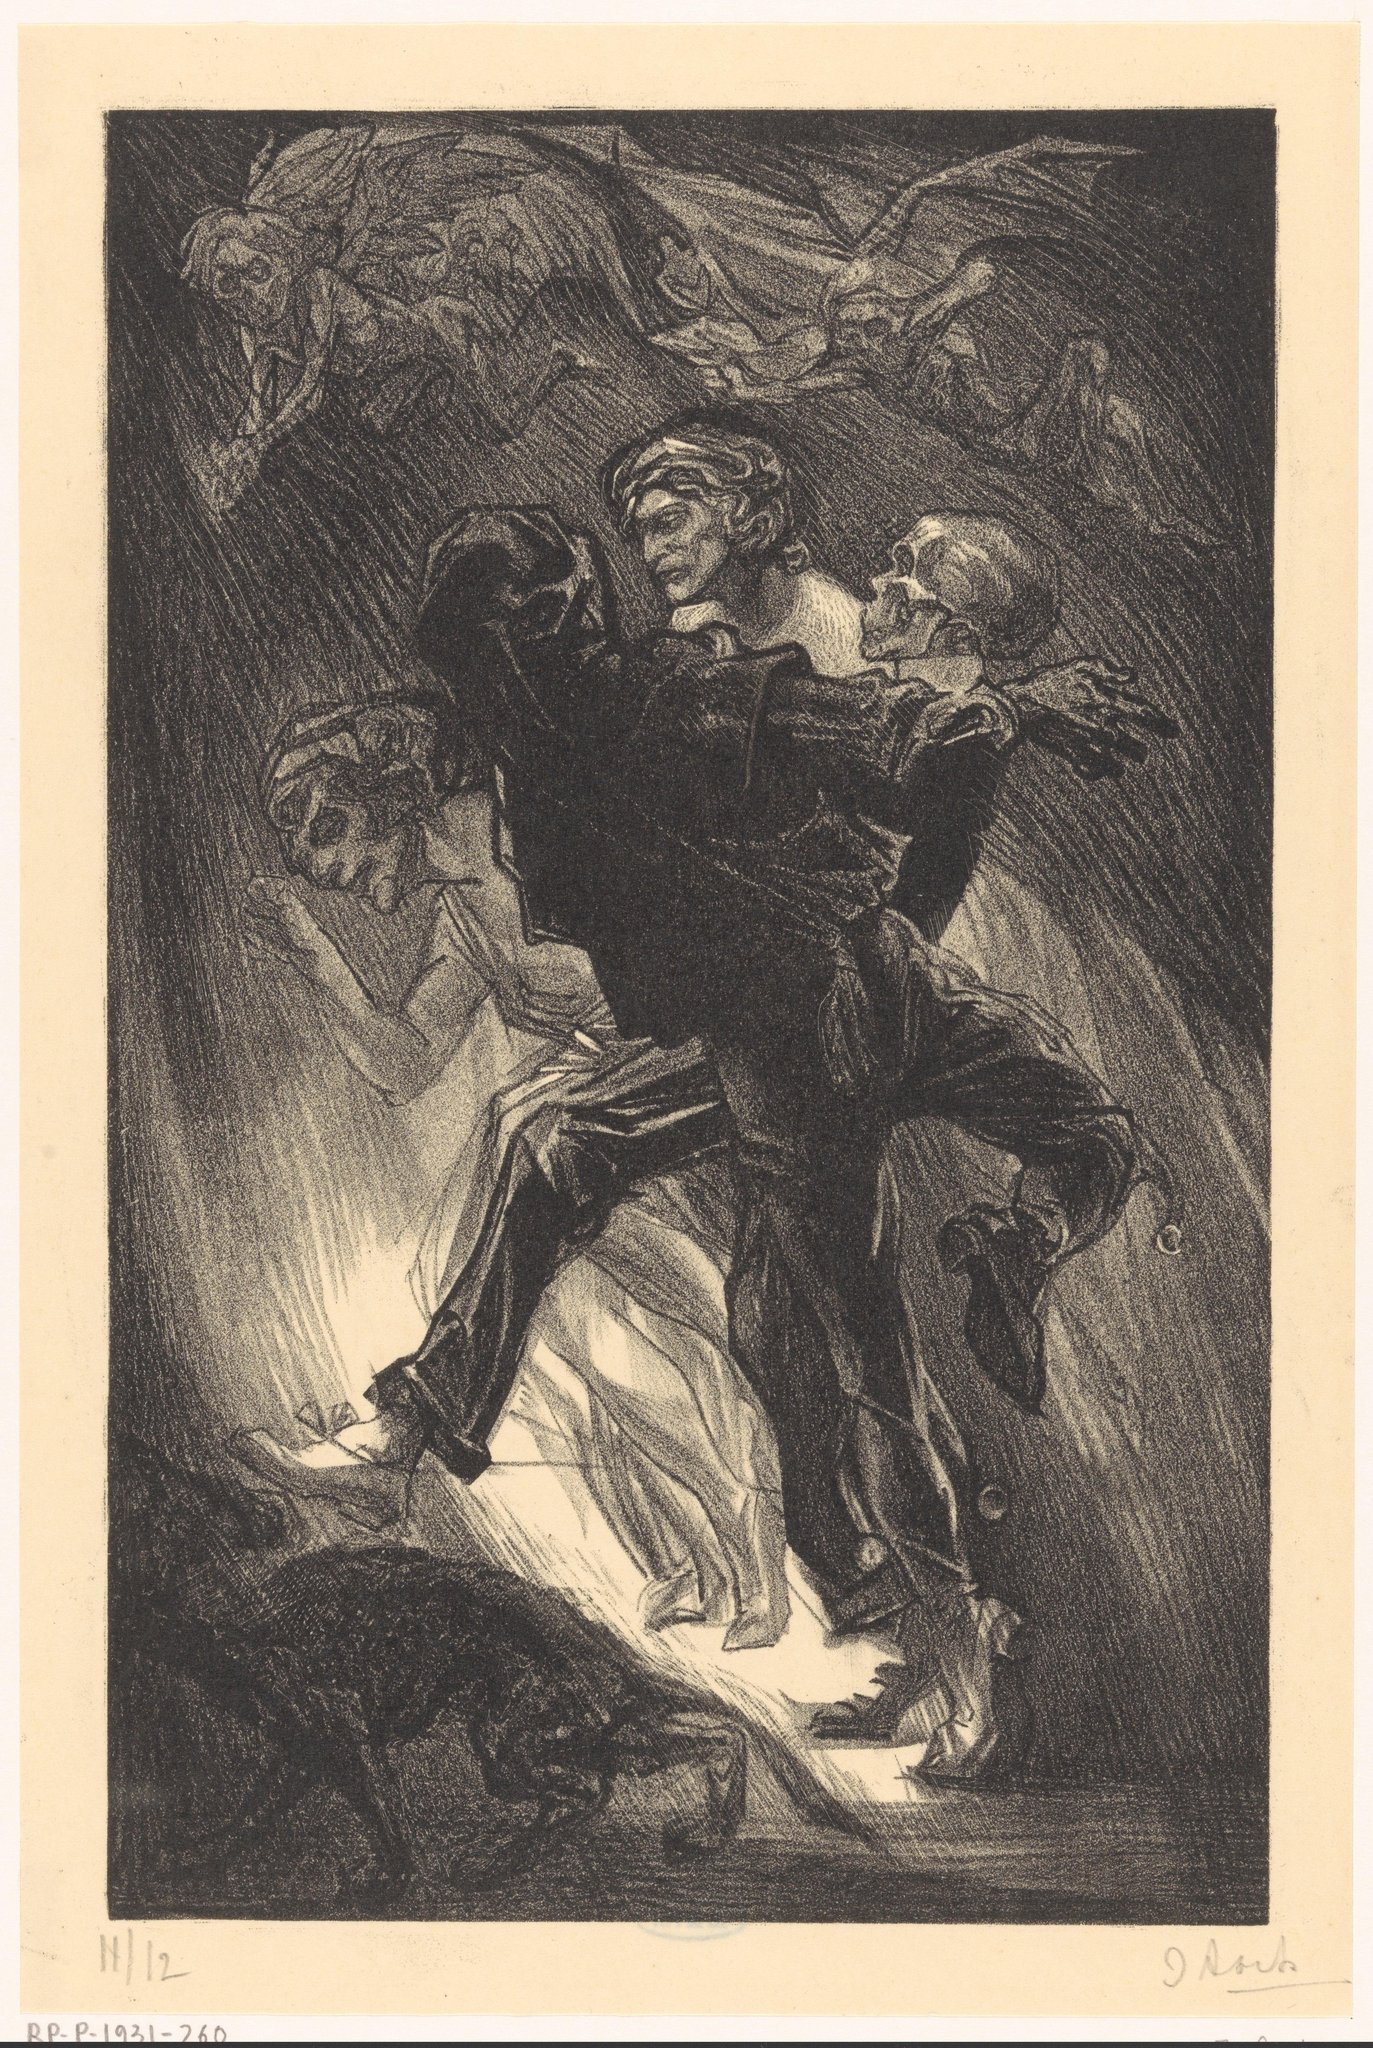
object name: print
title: Dodendans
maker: johannes josephus aarts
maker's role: draughtsman, print maker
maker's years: 1871-1934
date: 1927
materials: paper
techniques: lithograph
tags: court jester, court fool, devil(s) and demons, dance of death; death together with one or more human beings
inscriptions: collector's mark: Lugt 2228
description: Een groep van vier dansende figuren, waaronder een skelet in een pak en een nar. Boven hen twee gevleugelde duivels, waarvan één de armen zo houdt alsof hij met pijl en boog schiet. Links op de voorgrond een hond.